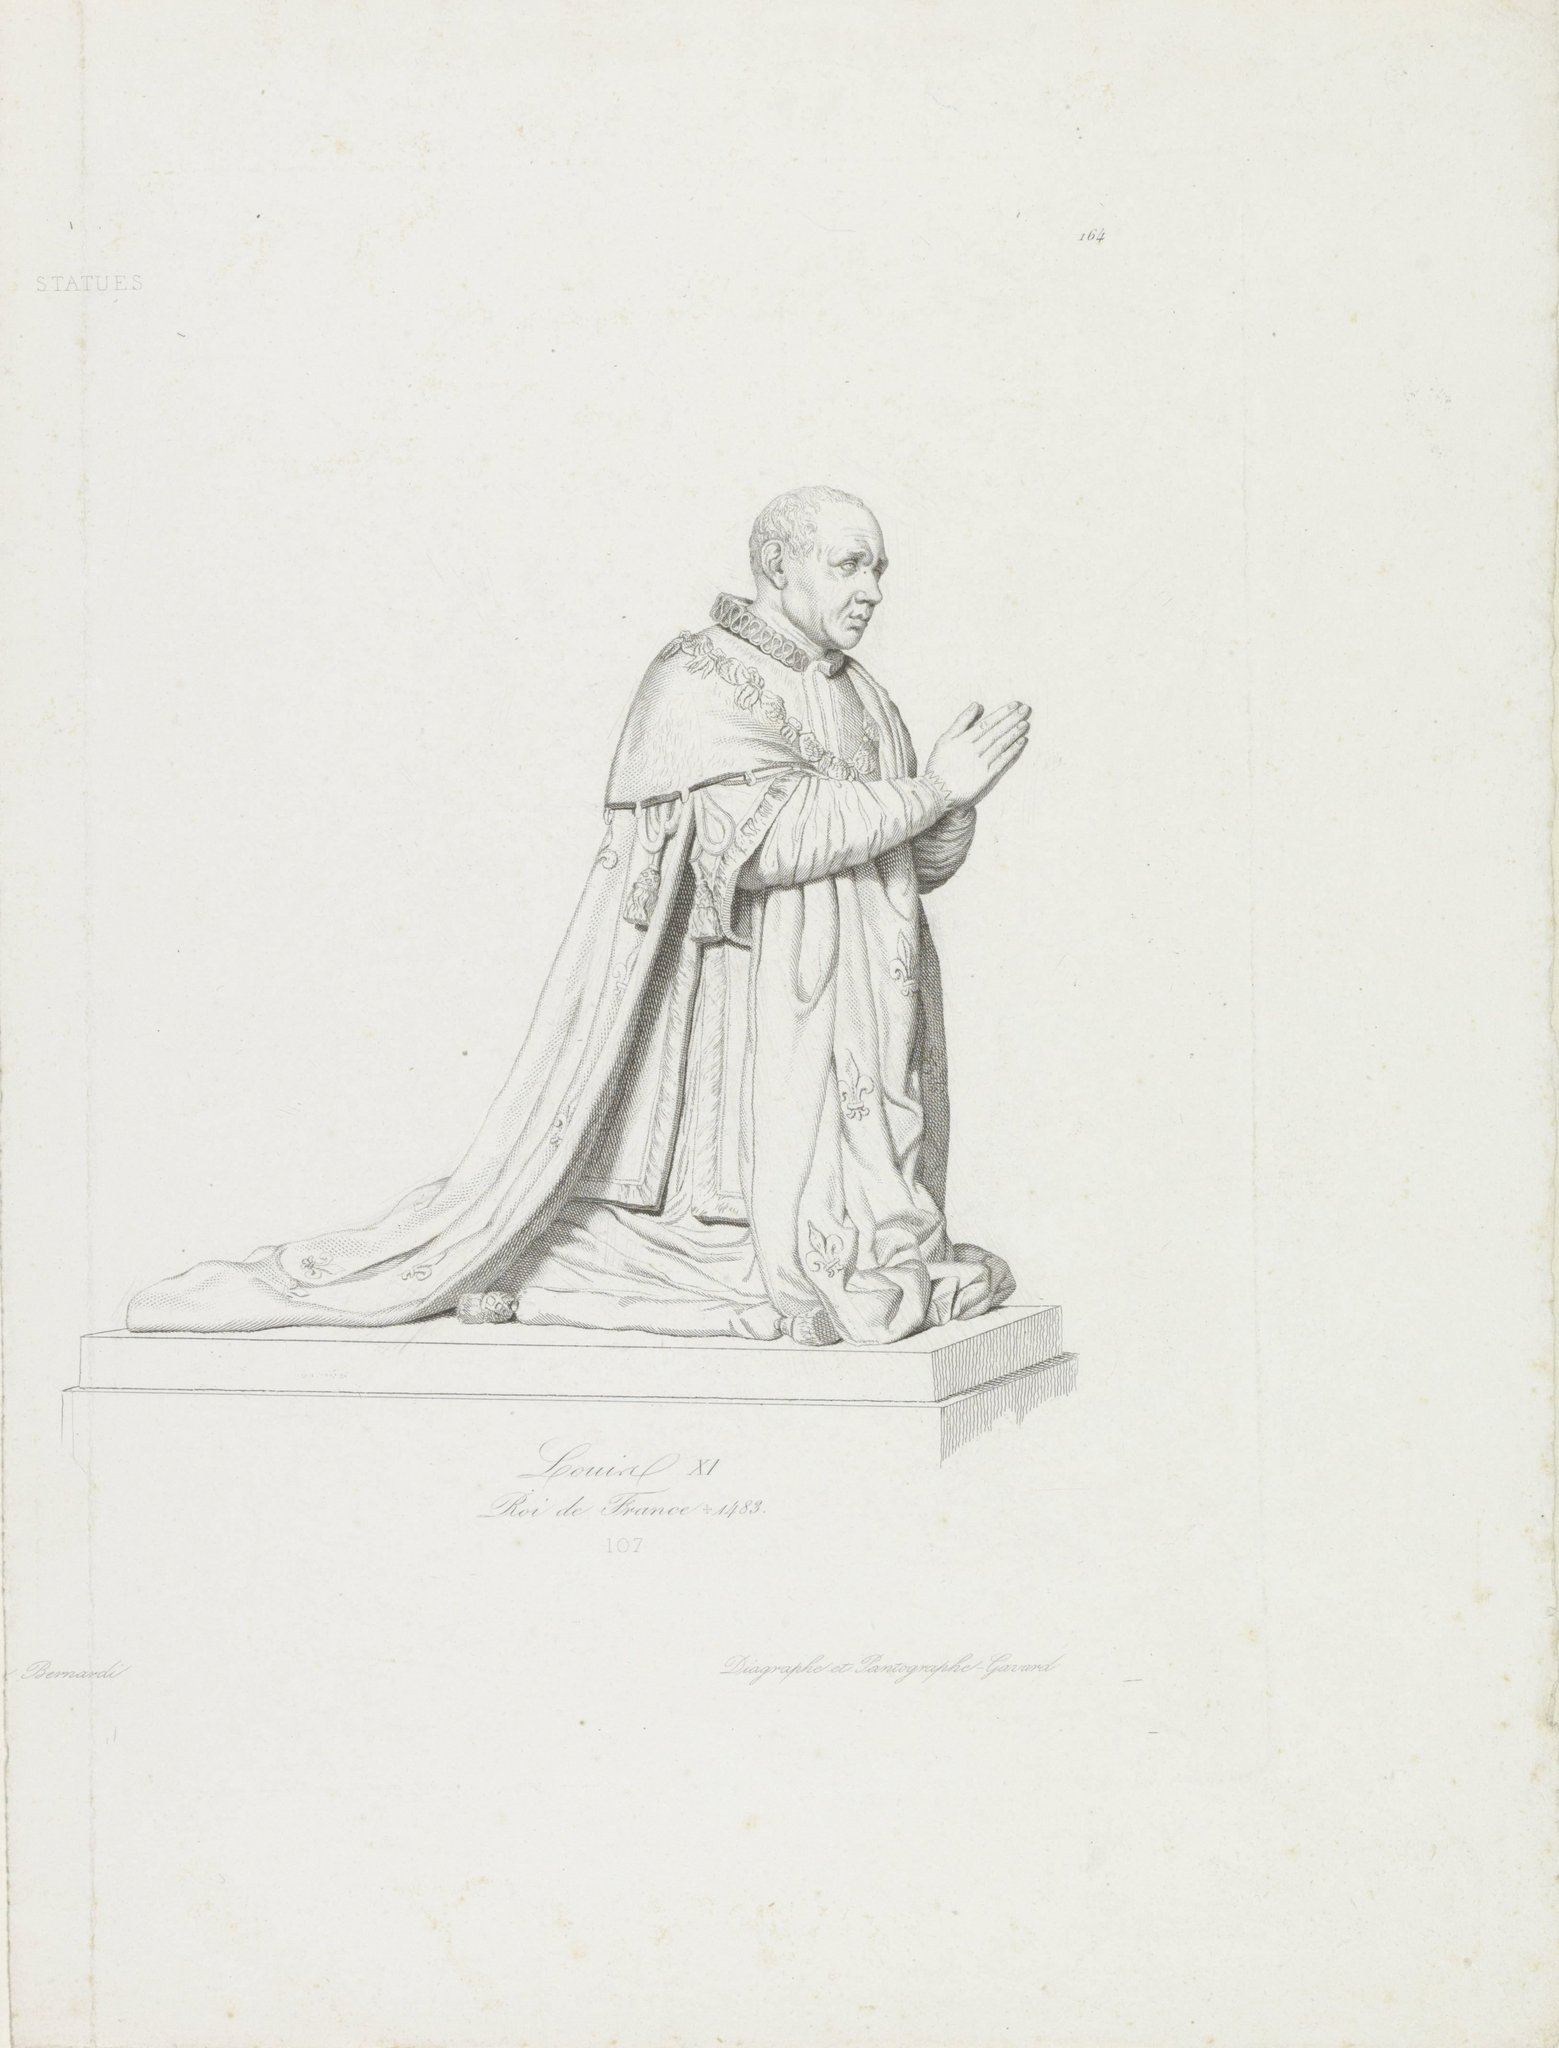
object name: print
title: Statues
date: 1818-1848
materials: paper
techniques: engraving, etching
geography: paris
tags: historical persons, piece of sculpture, reproduction of a piece of sculpture, ruler, sovereign, kneeling figure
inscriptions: collector's mark: Lugt 2228